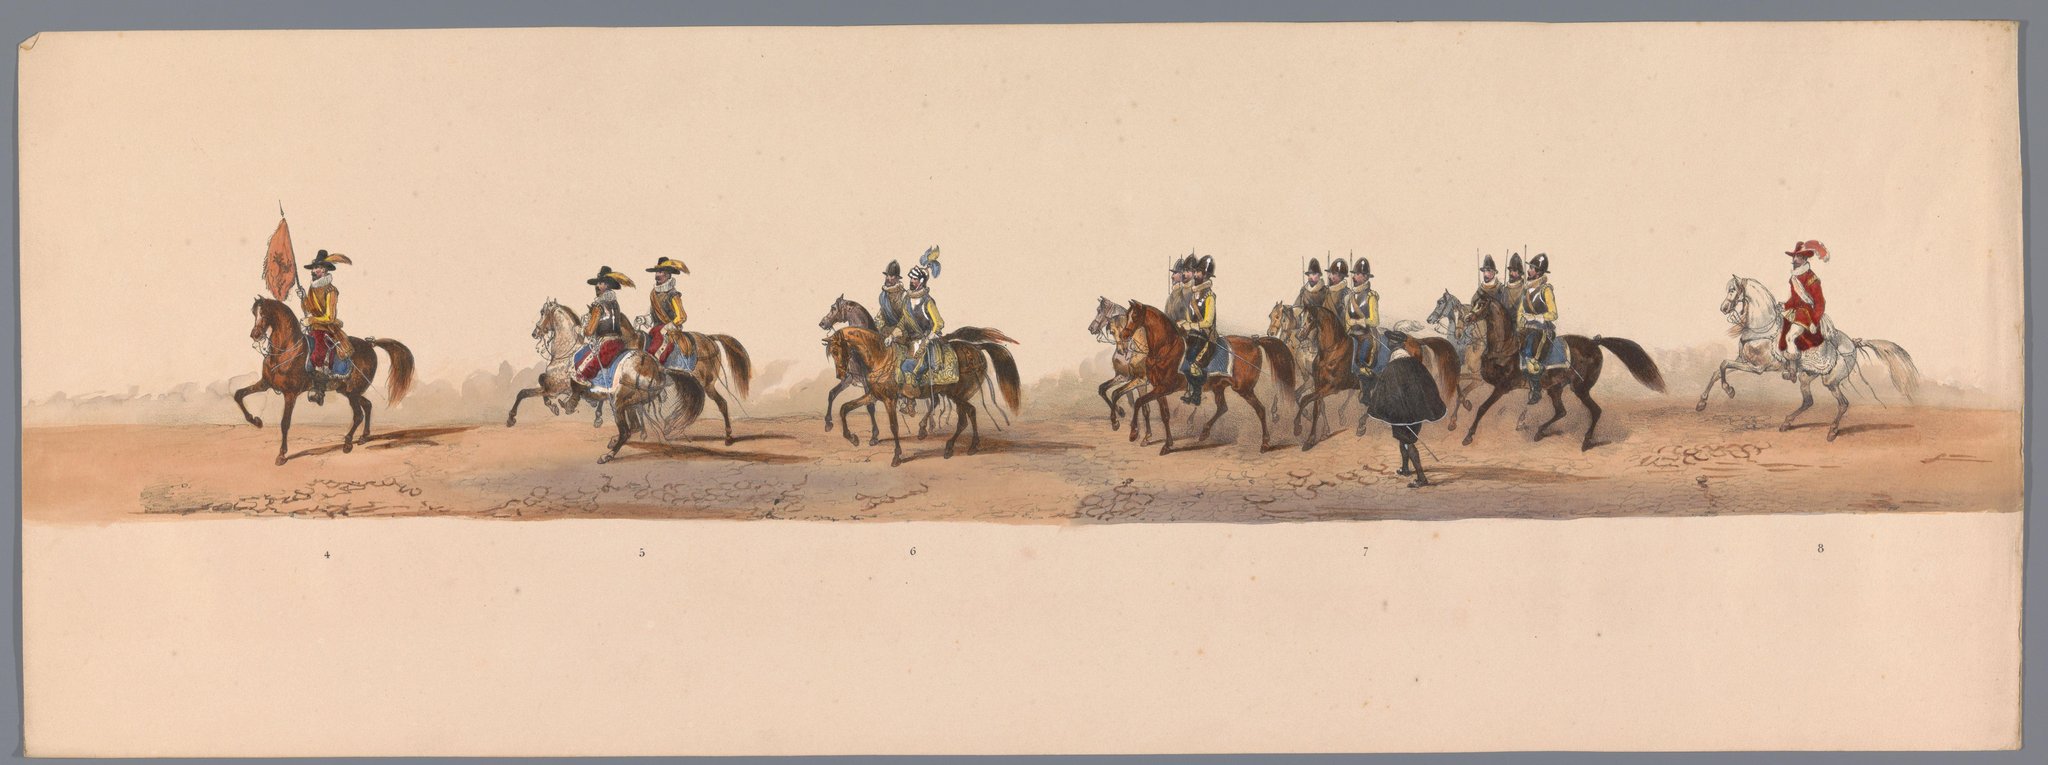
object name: print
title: Optogt des Nederlandschen Legers naar Ostende, den 3 July 1600, daags na de overwinning by Nieuwpoort; volgens de gecostumeerde voorstelling, gegeven door H H Studenten, by gelegenheid van het Tweede Eeuwfeest der Utrechtsche Hoogeschool. den 16 Juny 1836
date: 1837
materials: paper, watercolor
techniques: hand coloring, lithograph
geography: france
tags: students' pageant, costumes used in pageants, battle of nieuwpoort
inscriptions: date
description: Historische gekostumeerde optocht van de studenten van de Hogeschool van Utrecht op 16 juni 1836, bij de viering van het tweede eeuwfeest van de Utrechtse Hogeschool. De optocht verbeeldt de intocht van het Staatse leger in Oostende op 3 juli 1600, daags na de overwinning in de Slag bij Nieuwpoort. Tweede plaat in een serie van tien ongenummerde platen, met de groepen genummerd 4-8.